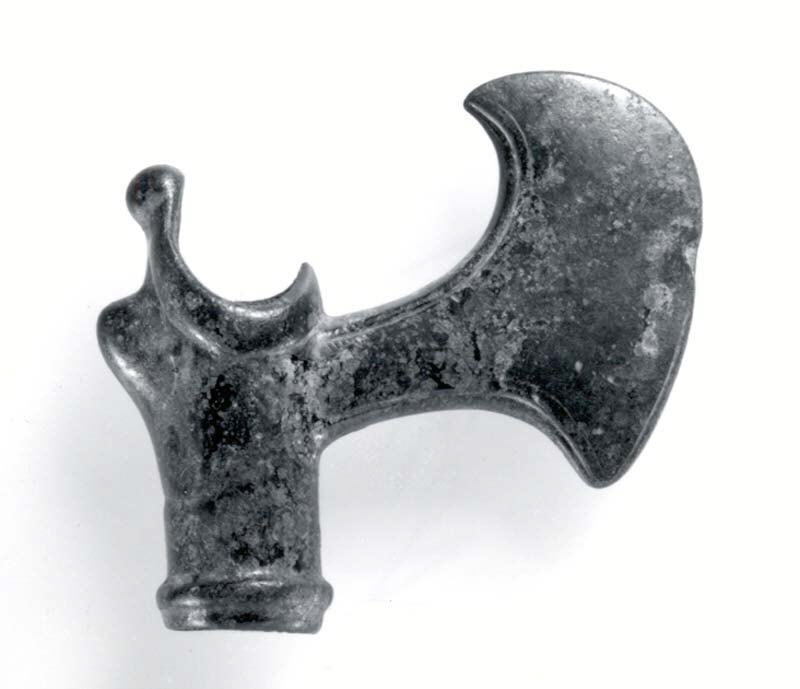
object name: axe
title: Axe head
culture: iranian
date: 2000-1500 BCE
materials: bronze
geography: western iran